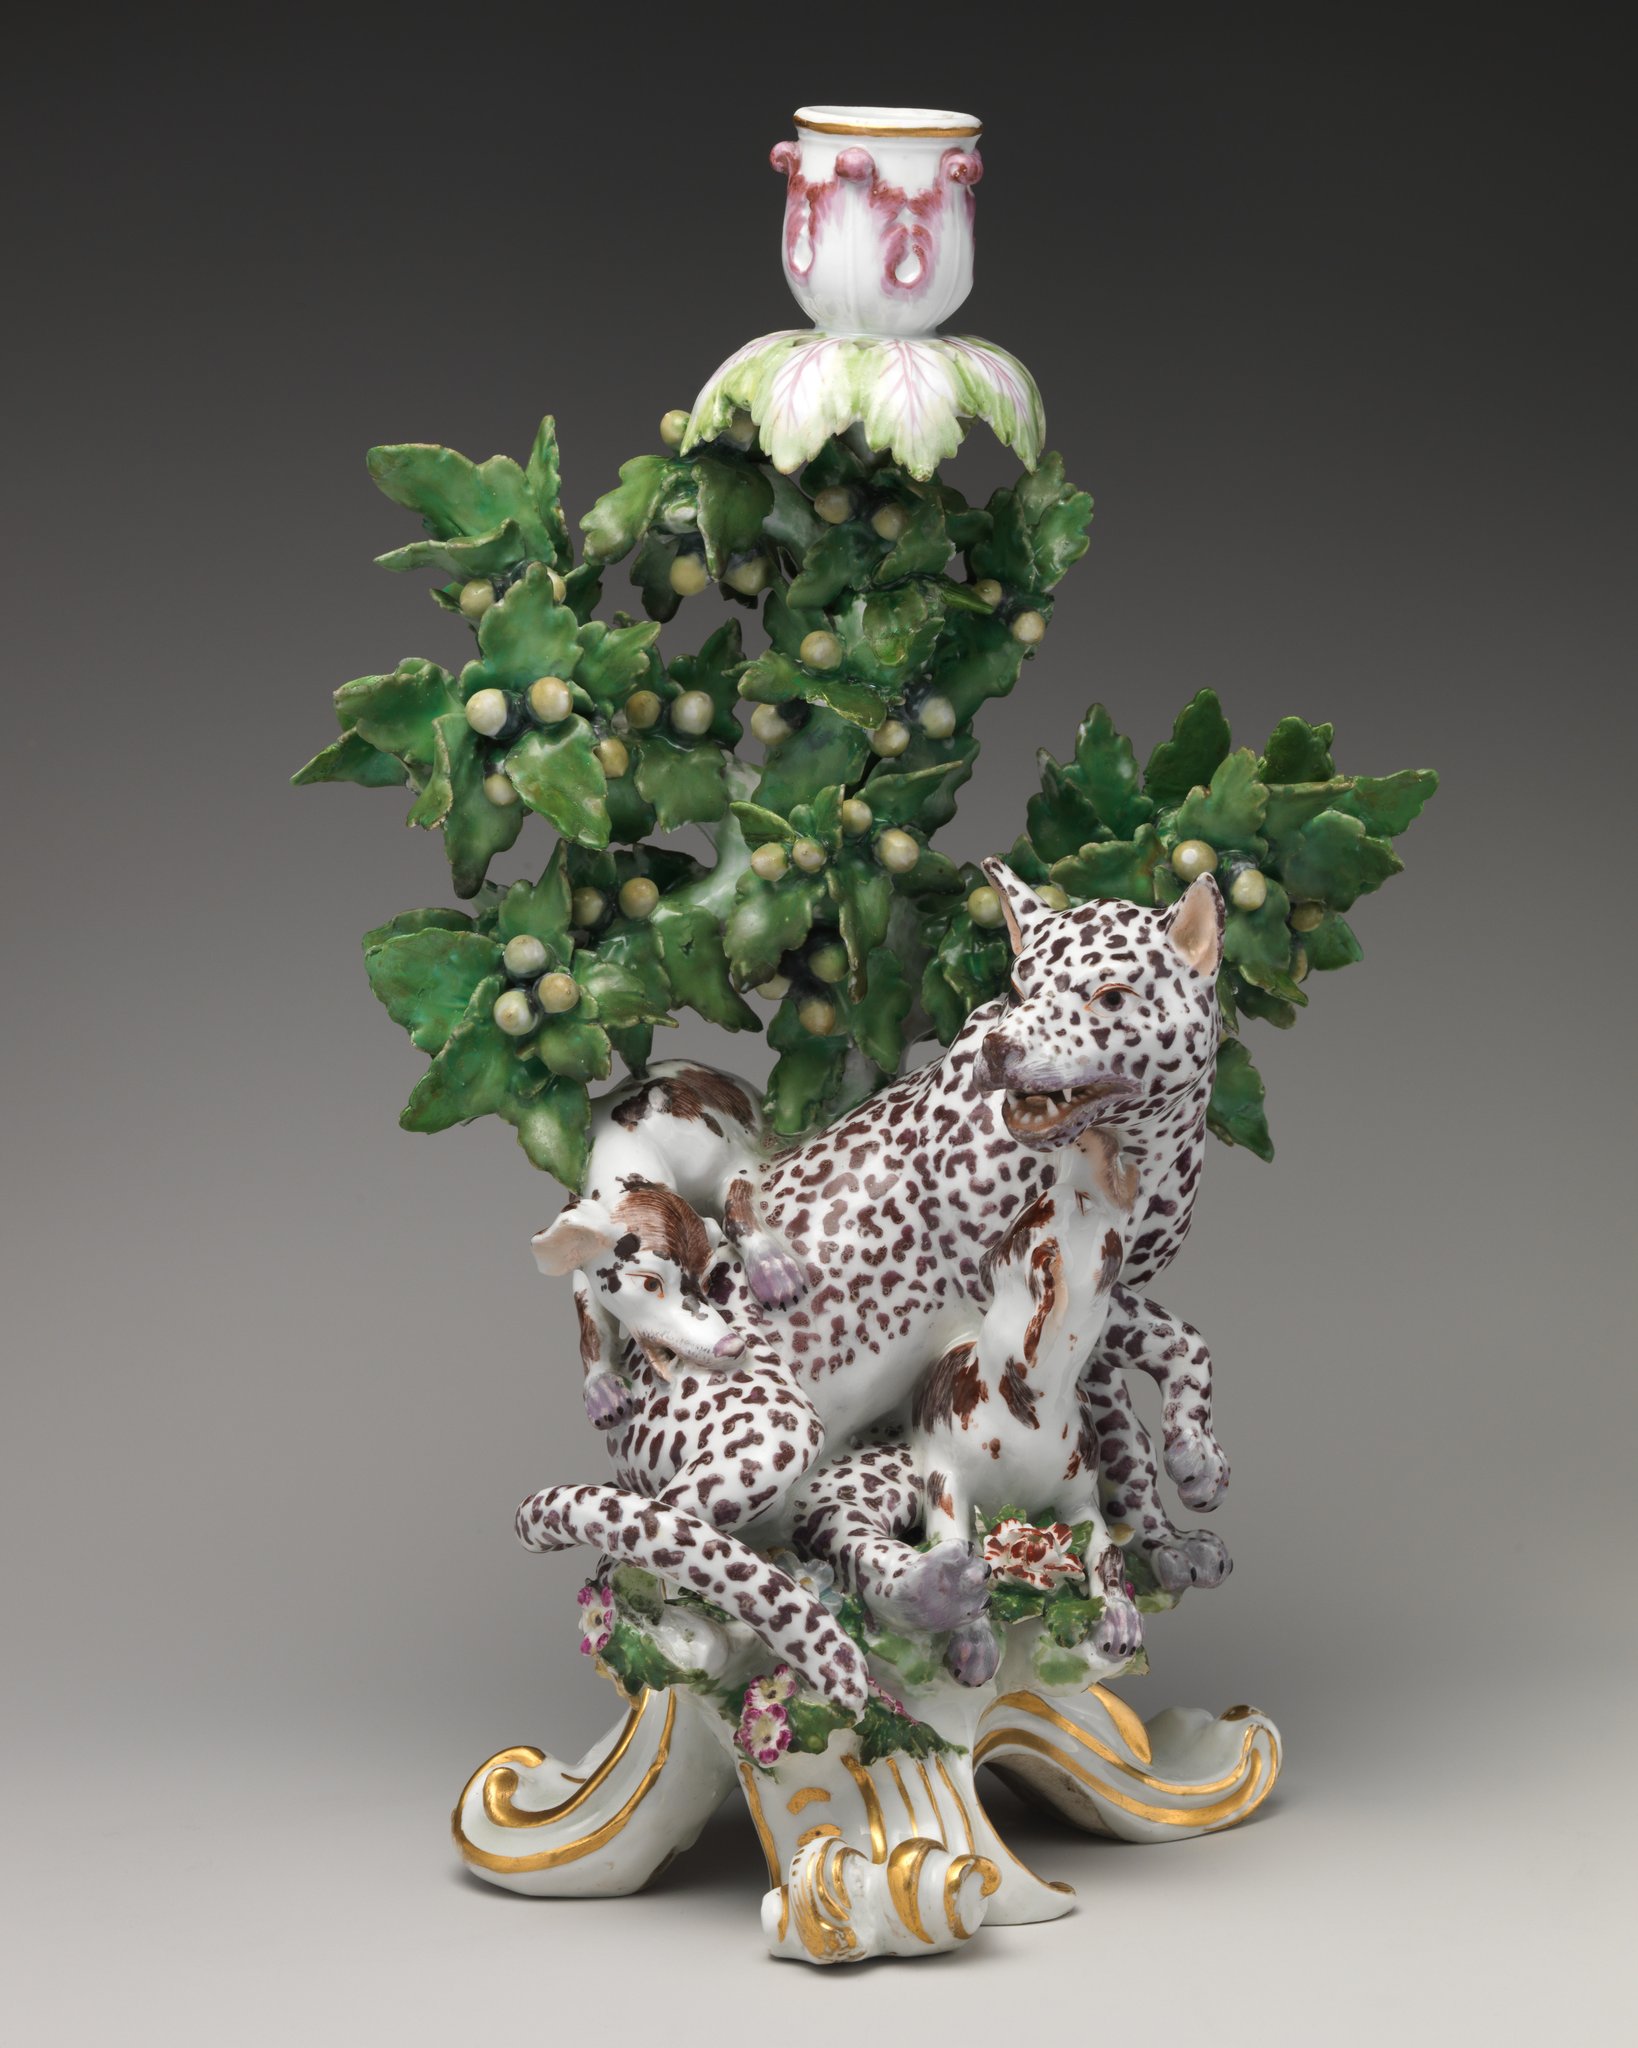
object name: candlestick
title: Candlestick (one of a pair)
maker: chelsea porcelain manufactory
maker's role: factory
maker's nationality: british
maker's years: 1744-1784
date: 1760-1765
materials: soft paste porcelain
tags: animals,plants